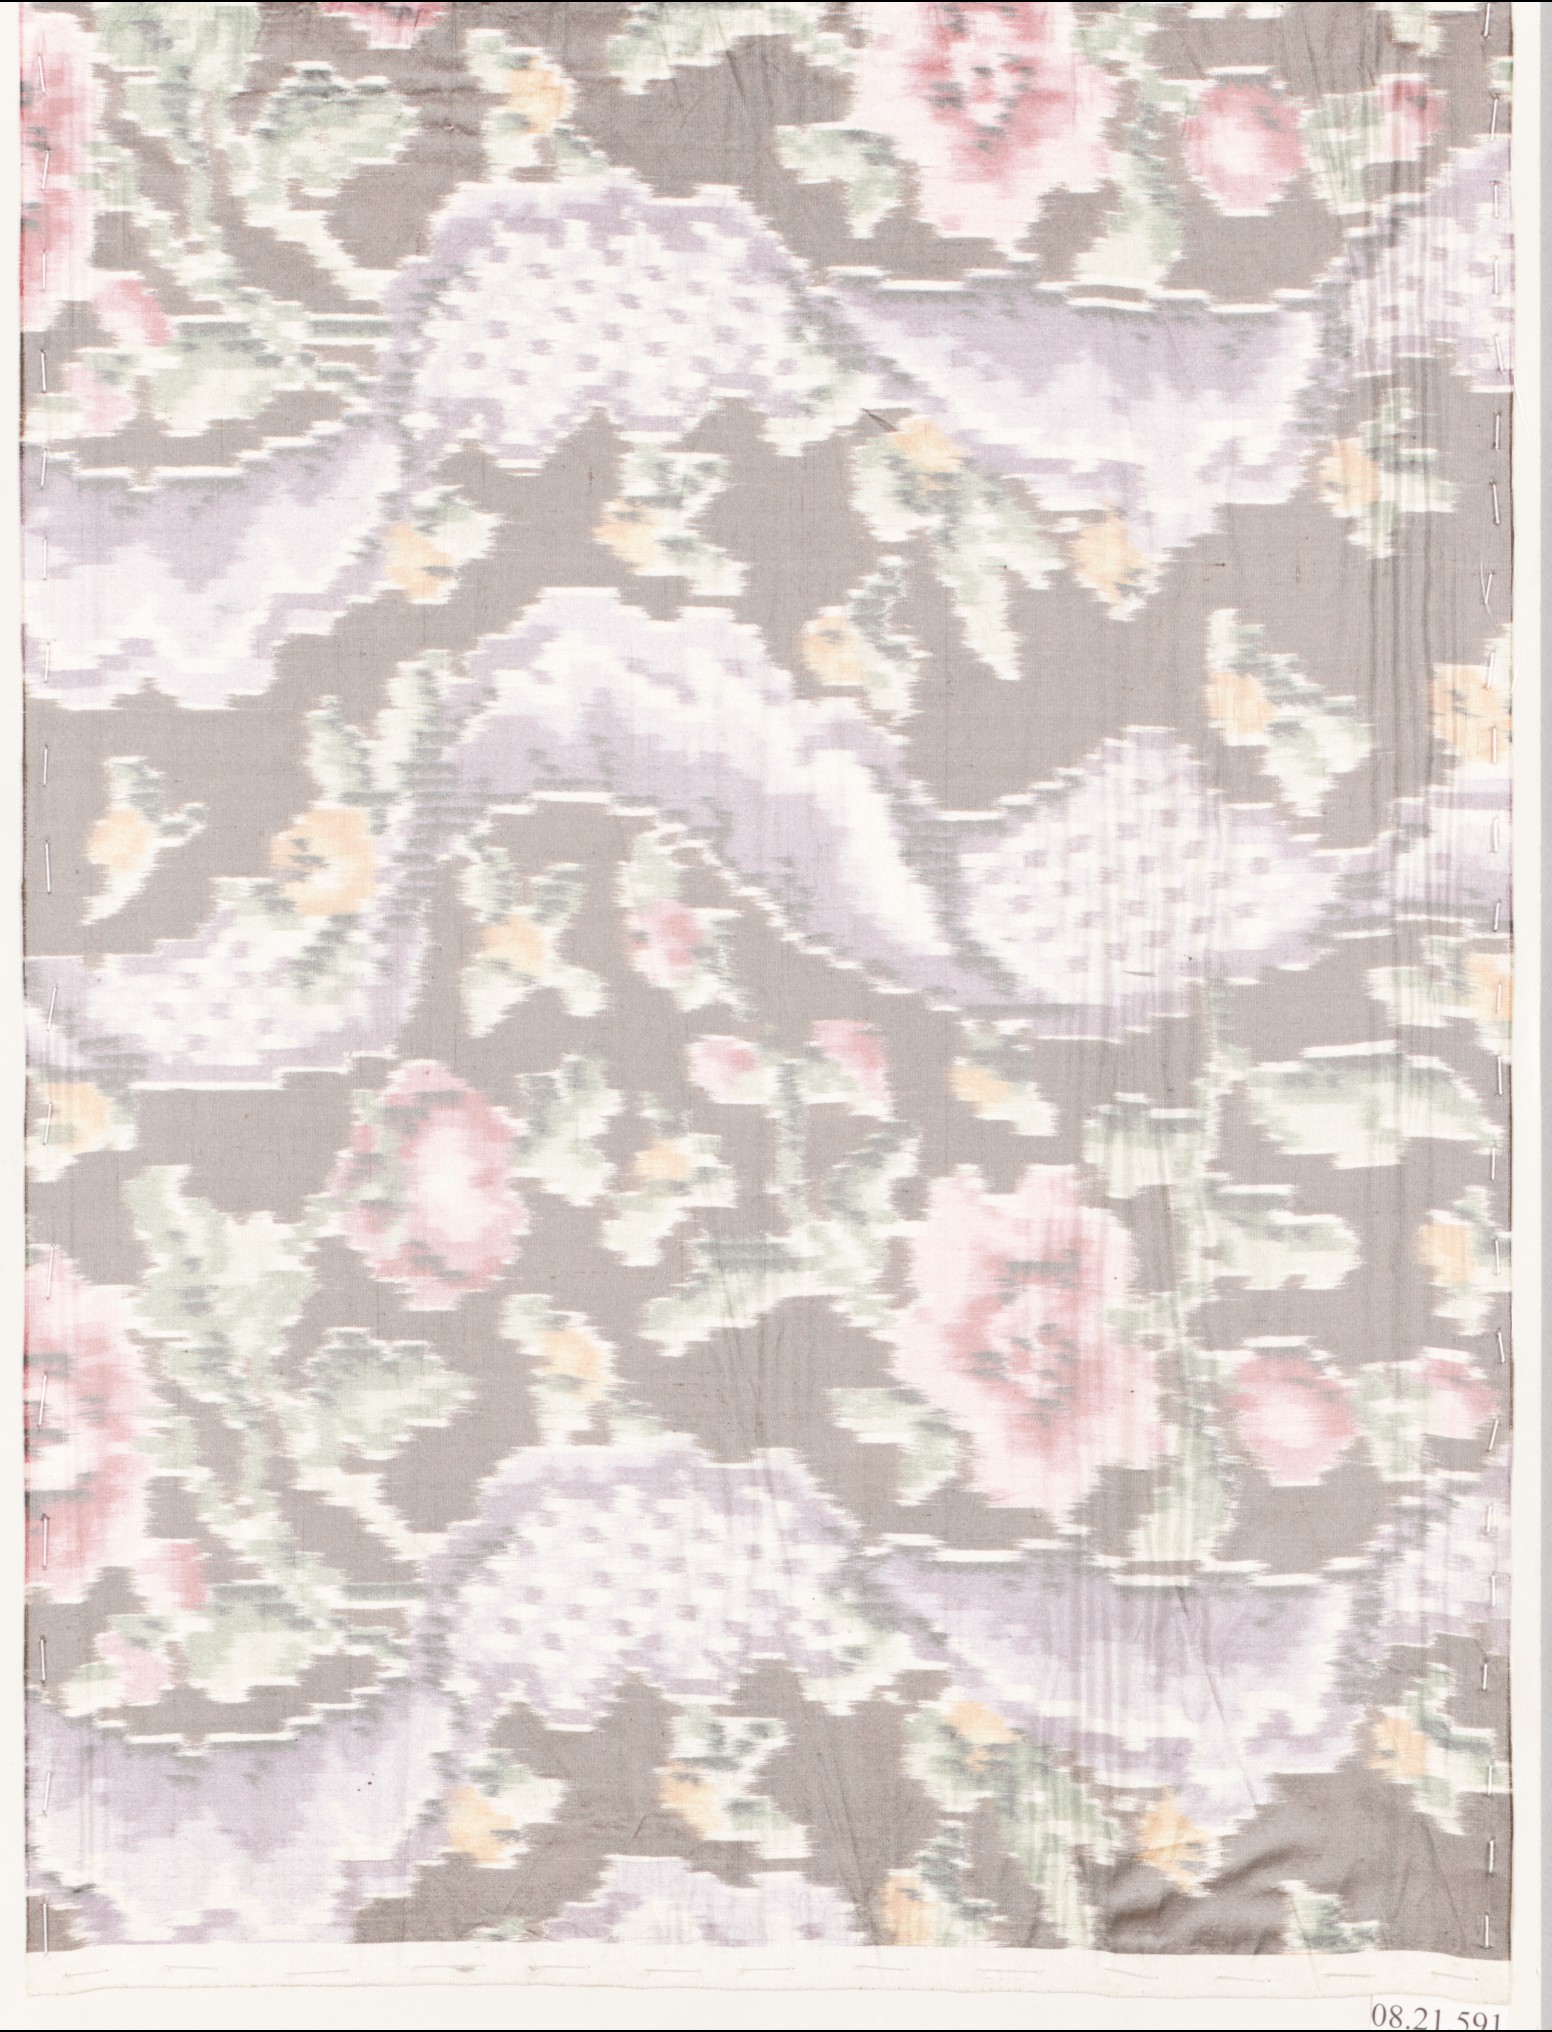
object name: textile sample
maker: Anonymous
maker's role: designer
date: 1900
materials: silk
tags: flowers